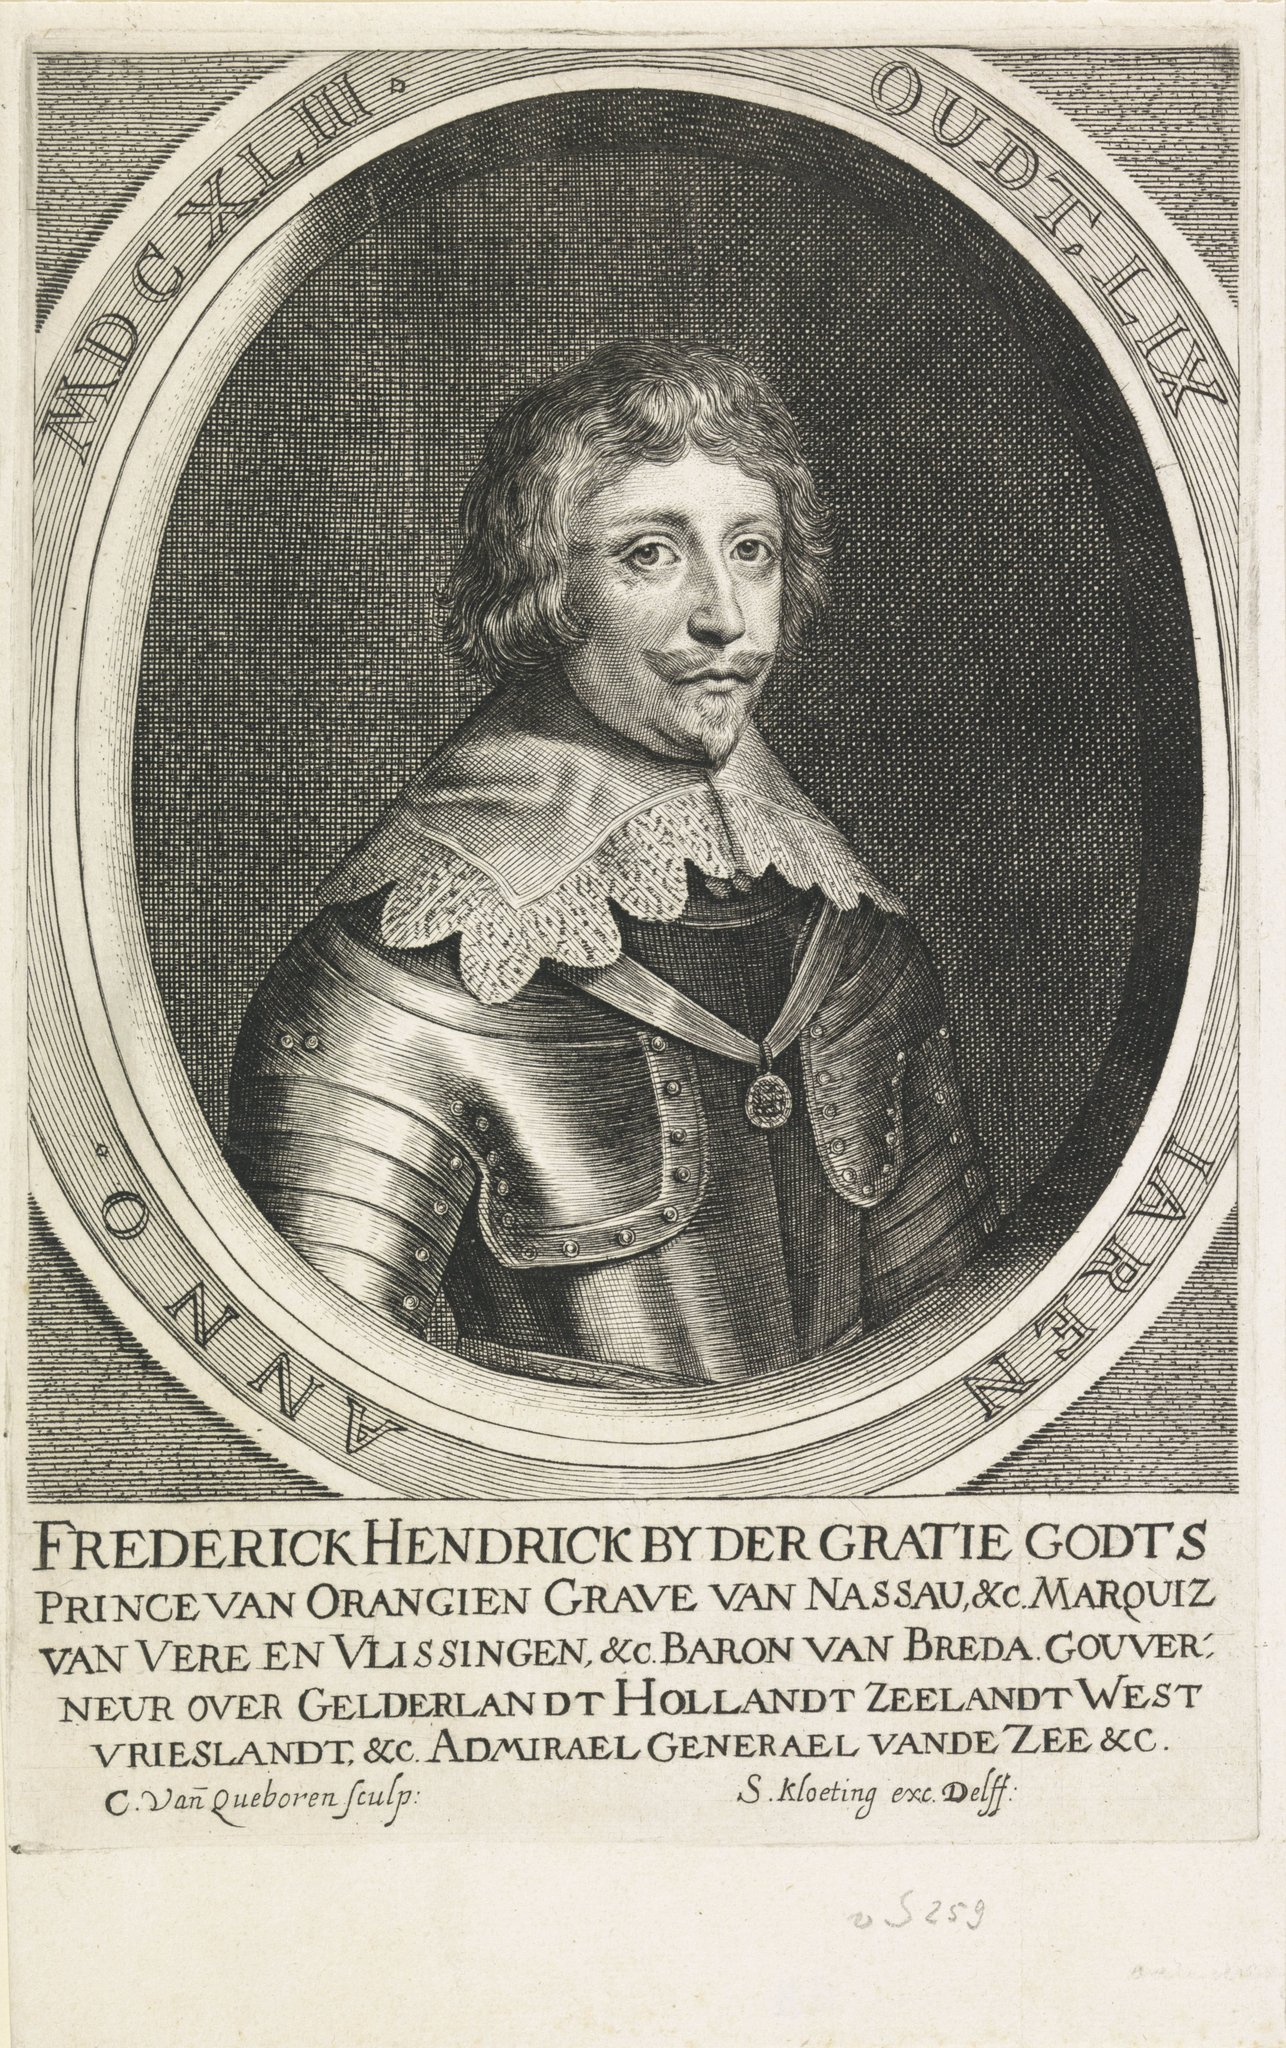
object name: print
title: Portret van Frederik Hendrik, prins van Oranje, op 59-jarige leeftijd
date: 1643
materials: paper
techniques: engraving, etching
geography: delft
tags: frederick henry (prince of orange), knighthood order (garter) - insignia of a knighthood order, e.g.: badge, chain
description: De hier vermelde titel verwijst naar de hoogst verkregen titel van de geportretteerde, niet per se naar de titel die de geportretteerde op deze voorstelling draagt.